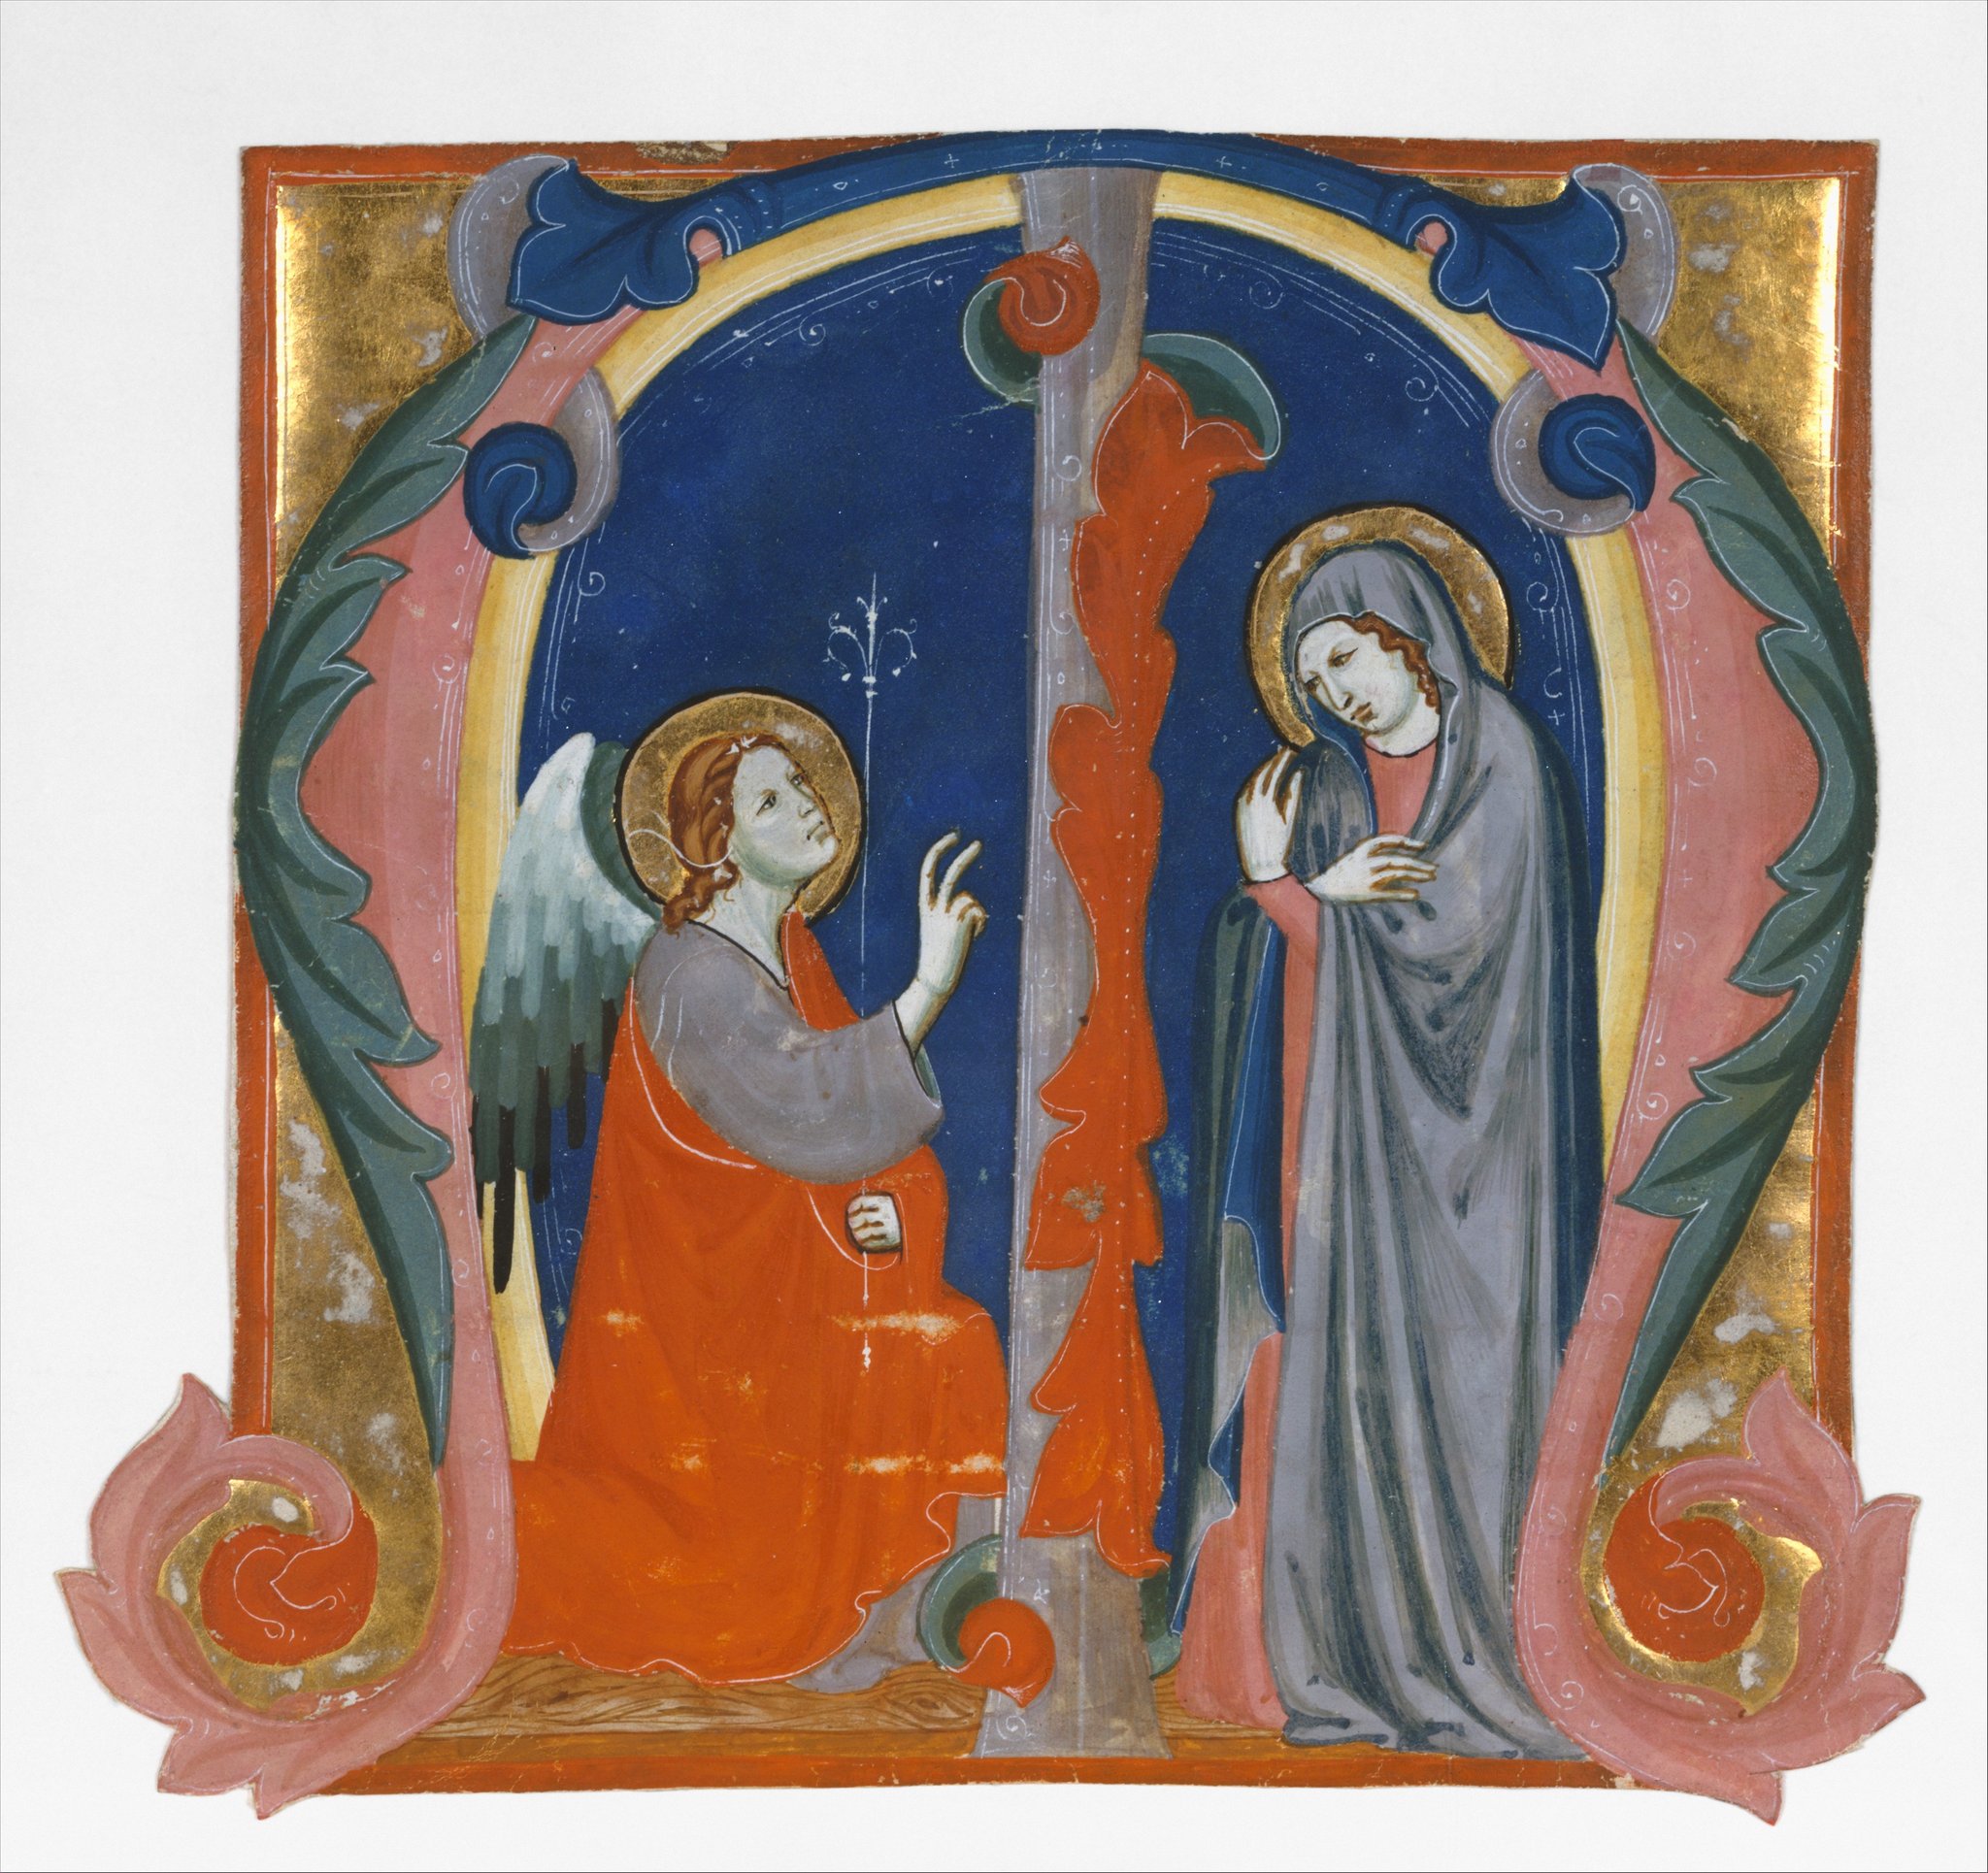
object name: cutting from an antiphonary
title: Annunciation in an Initial M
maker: maestro daddesco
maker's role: artist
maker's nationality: italian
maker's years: 1320-1340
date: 1310-1315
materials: gold, parchment, paint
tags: virgin mary,archangel gabriel,annunciation